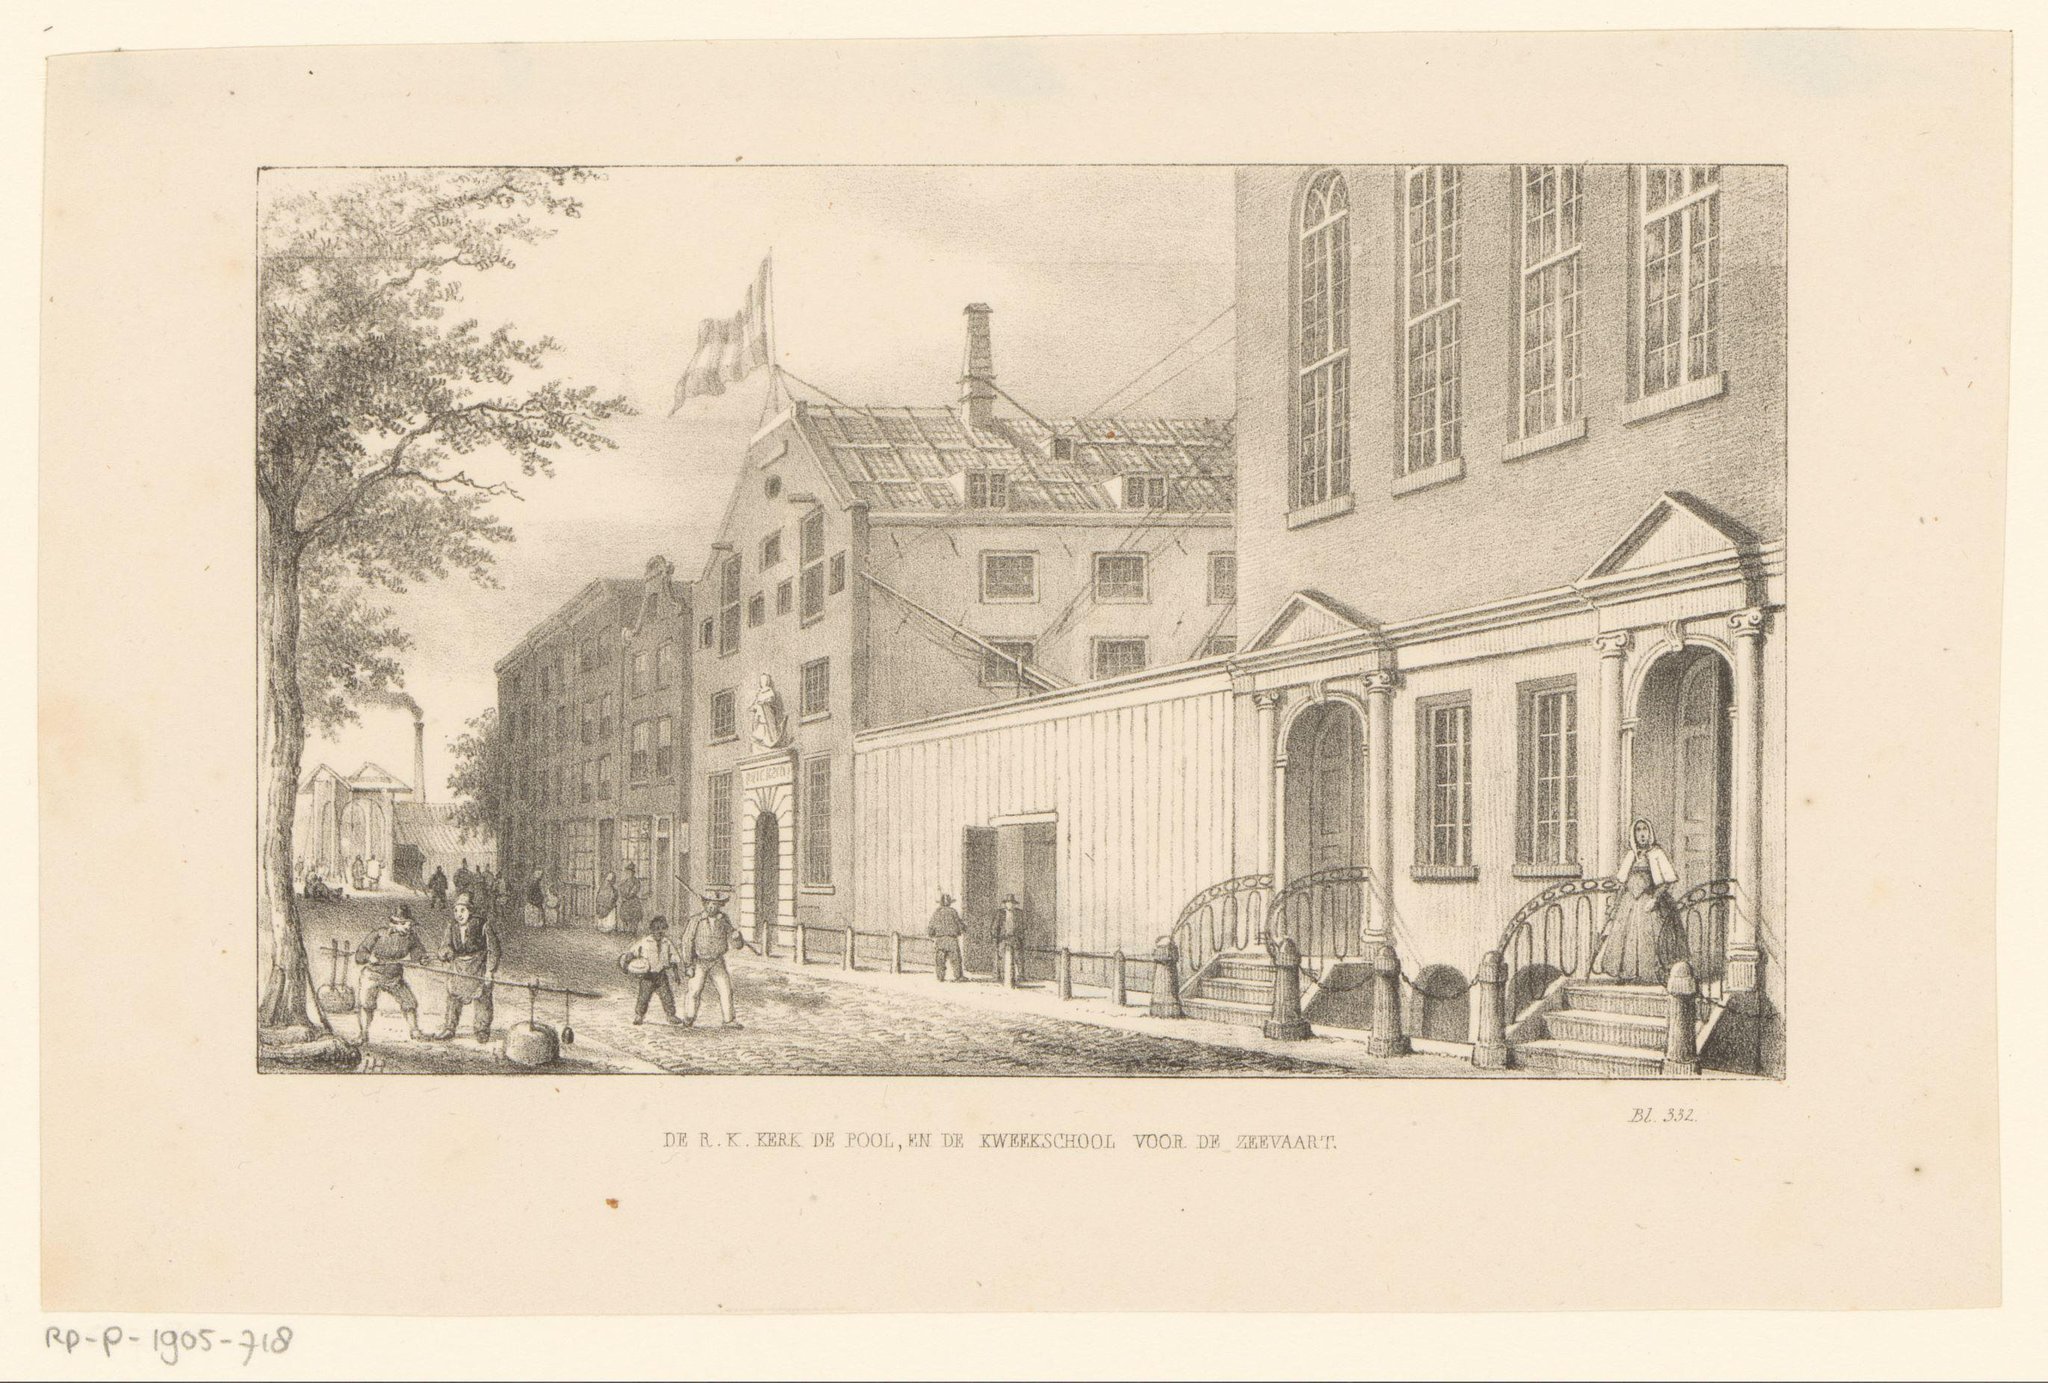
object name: book illustration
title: De R.K. Kerk de Pool, en de Kweekschool voor de zeevaart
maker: johannes hilverdink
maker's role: draughtsman, painter, print maker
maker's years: 1813-1902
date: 1844-1848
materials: paper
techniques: lithograph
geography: amsterdam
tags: further education, church (exterior), street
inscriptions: collector's mark: Lugt 2228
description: Prent uit: Vijver, C. van der. Geschiedkundige beschrijving der stad Amsterdam. Amsterdam: Diederichs, Gebroeders, 1844-1848.